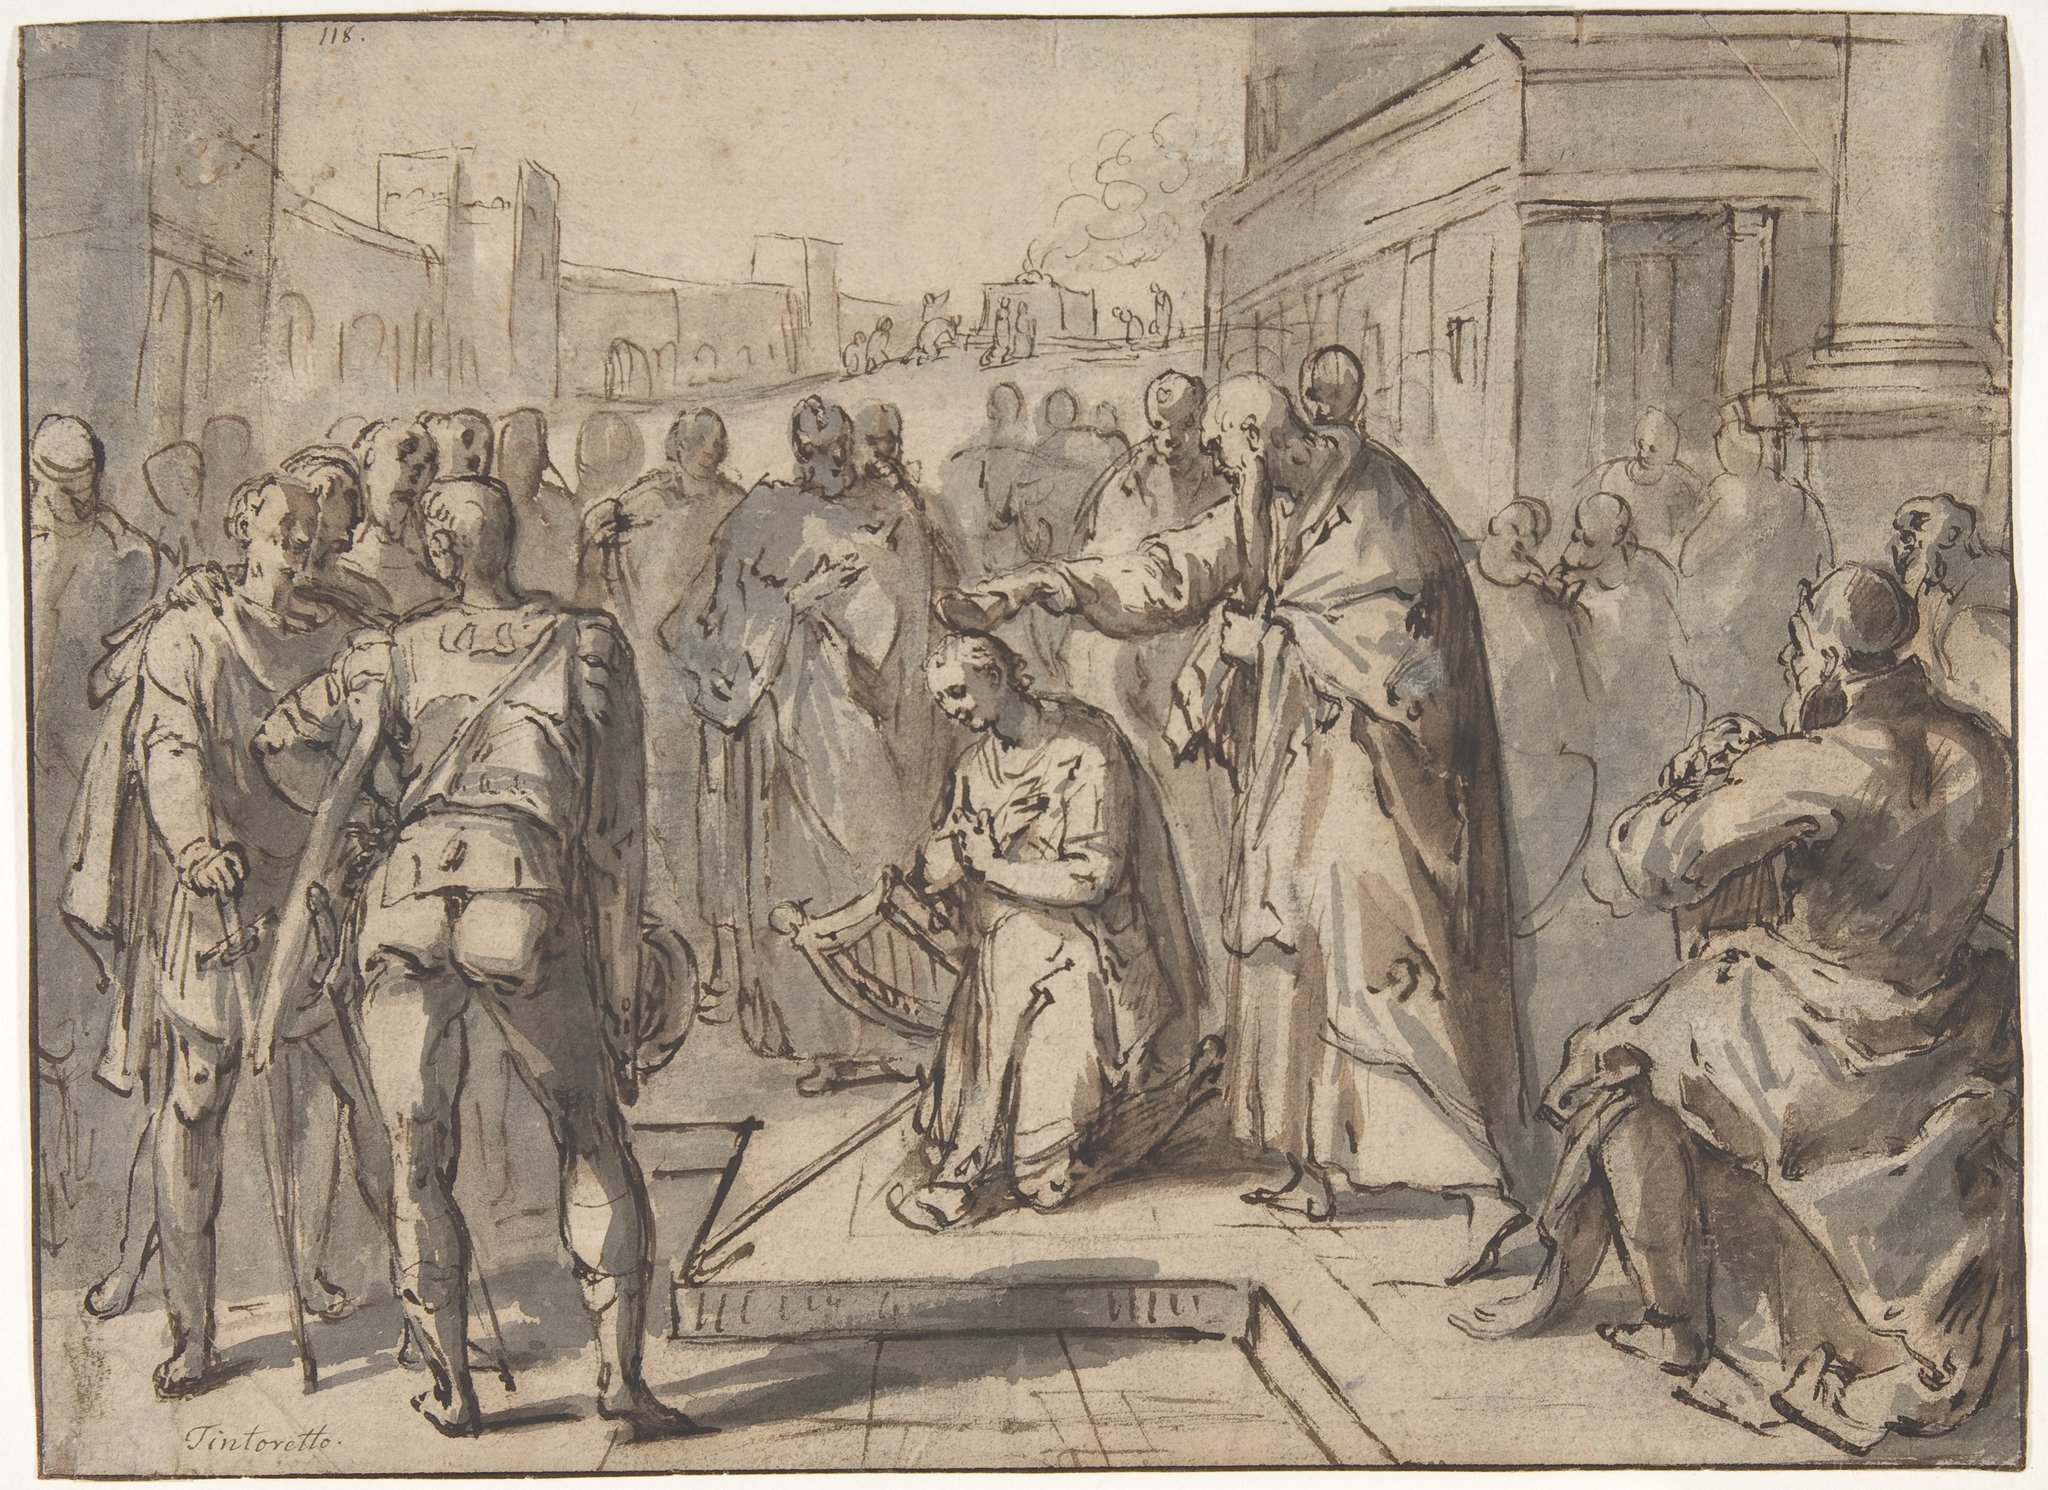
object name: drawing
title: Samuel Annointing David (recto); Sketch of two figures (verso)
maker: karel van mander (i)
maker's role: artist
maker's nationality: netherlandish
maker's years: 1548-1606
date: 1591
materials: chalk, ink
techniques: brush, incising, pen, wash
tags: buildings,men,david,crowd